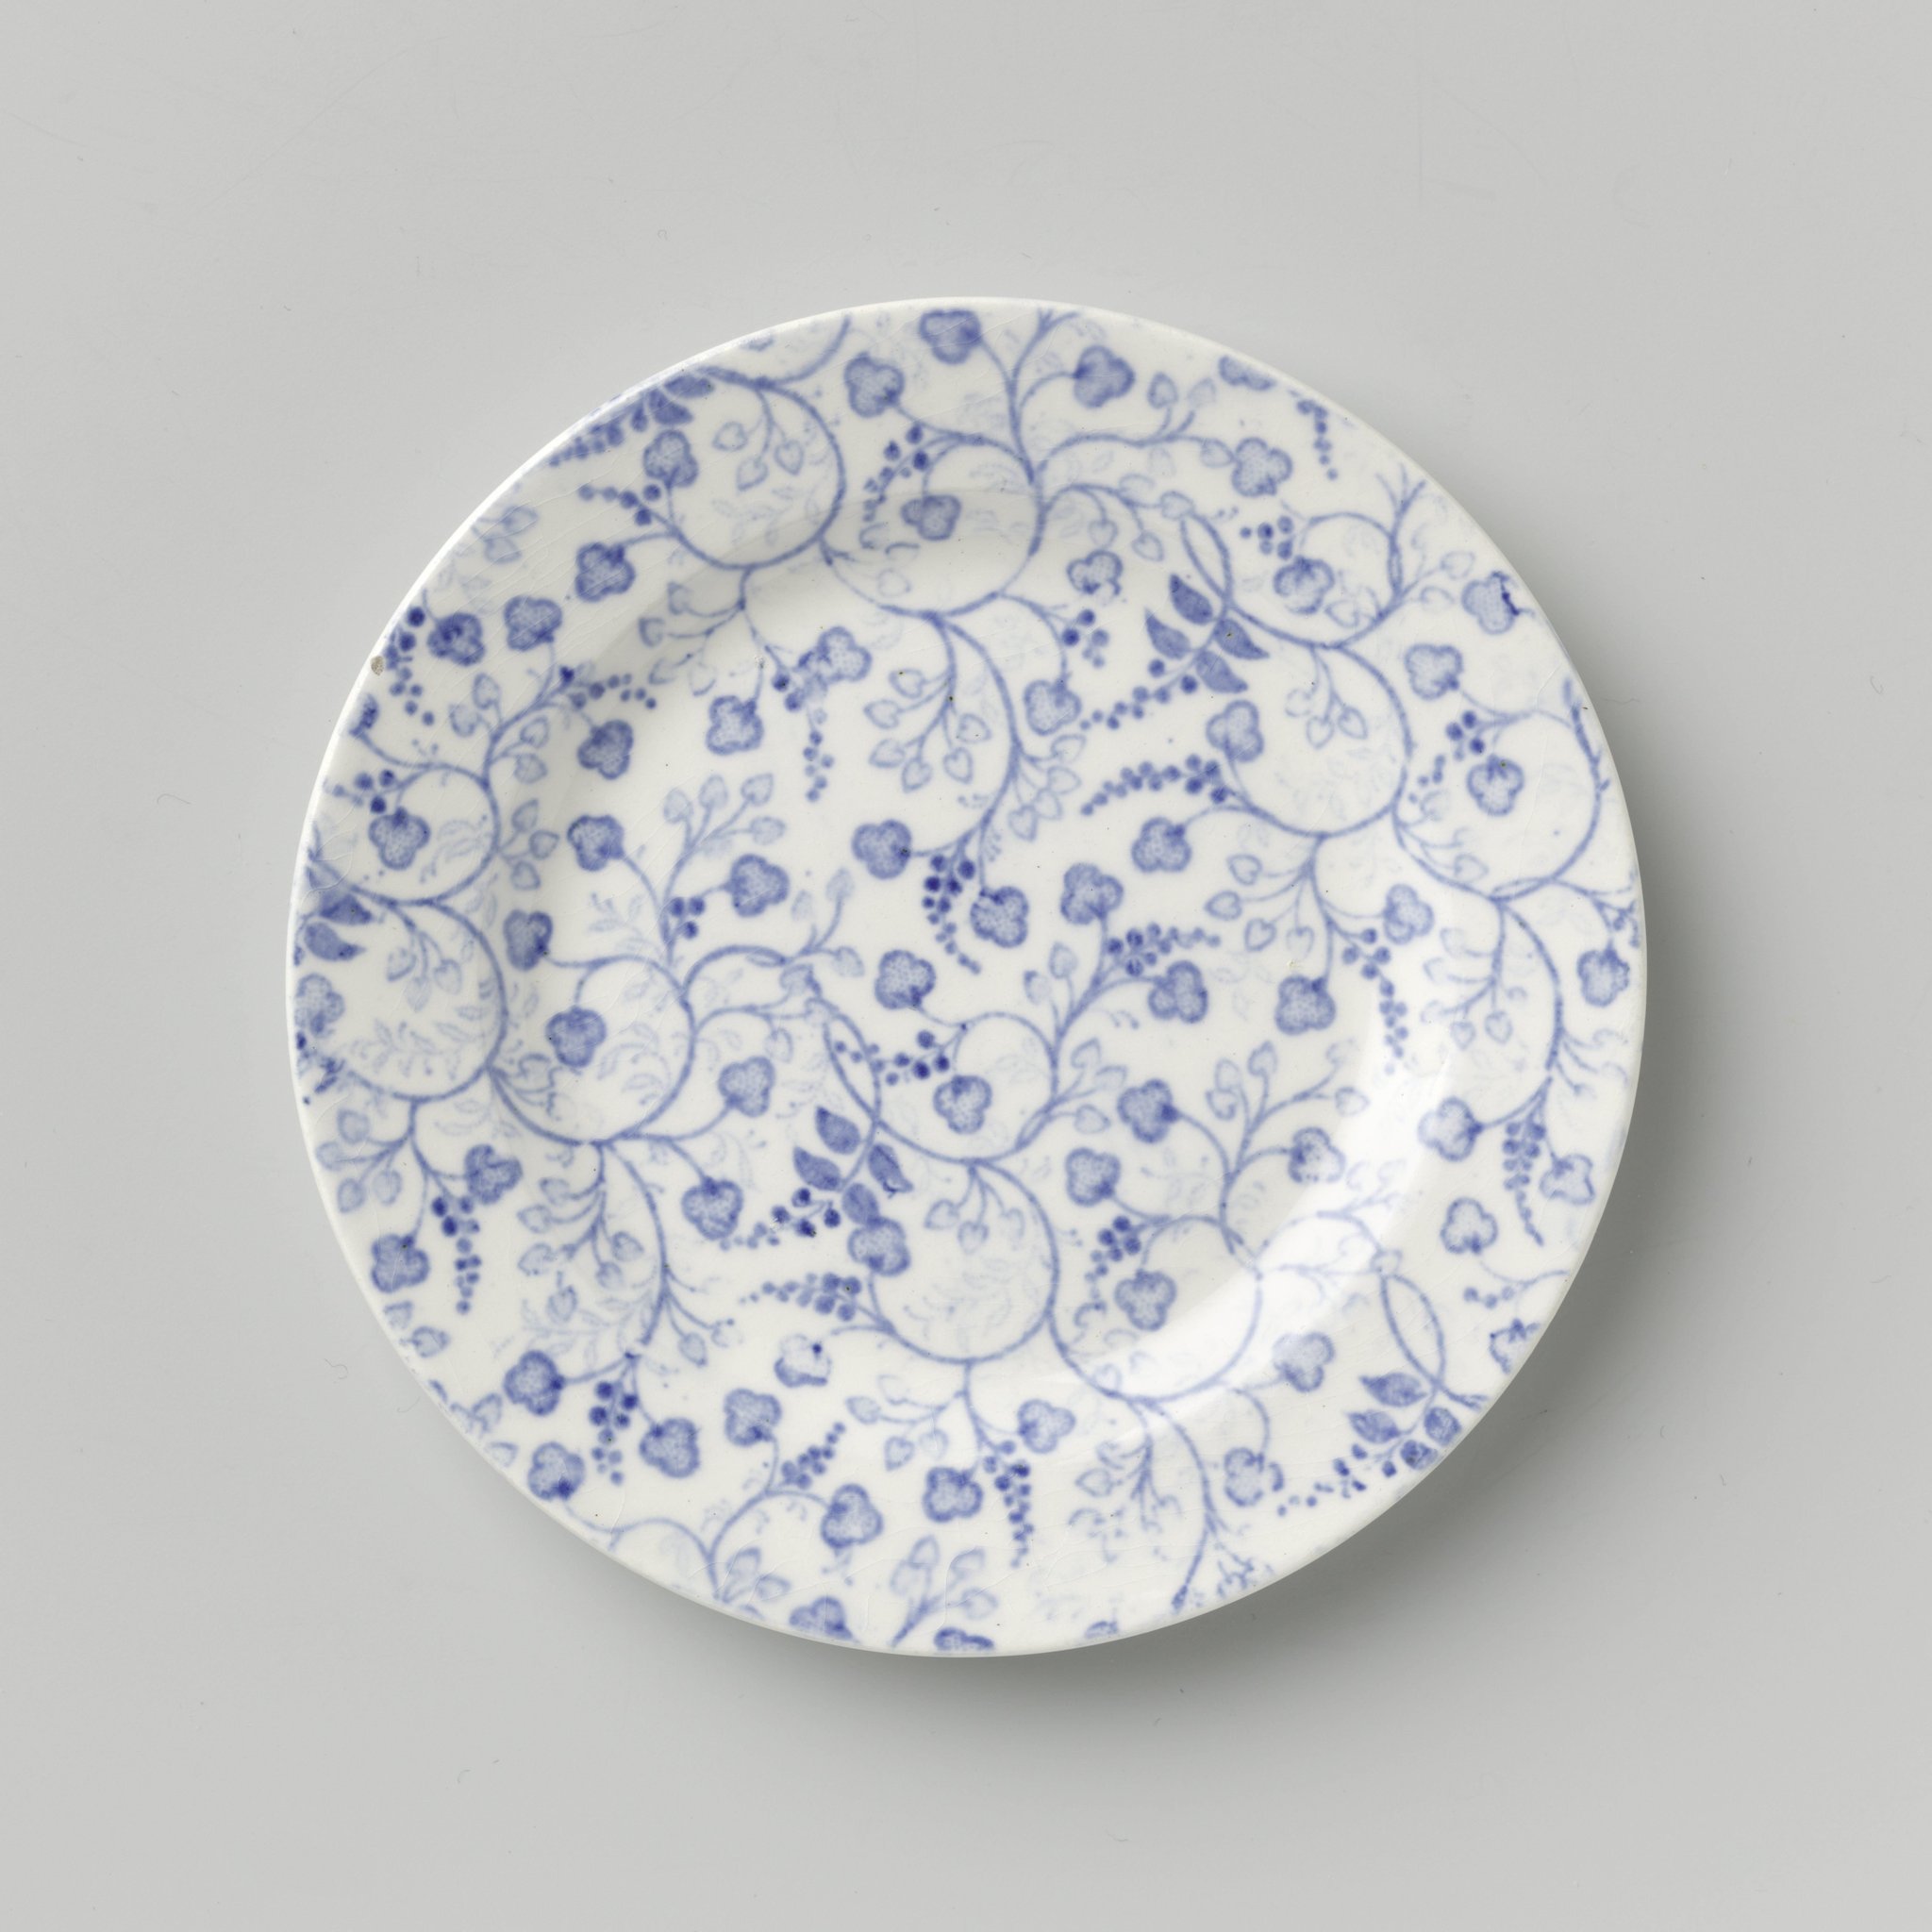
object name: plate dish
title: Bord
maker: petrus regout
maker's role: plateelbakker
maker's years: 1801-1879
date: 1867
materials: creamware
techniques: transfer decoration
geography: maastricht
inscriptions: mark: ‘PARSEME No 3’, check stamp: ‘PR // 29’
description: Bord van aardewerk, met blauw doorlopend bloemendecor, behorend tot een kinderservies.